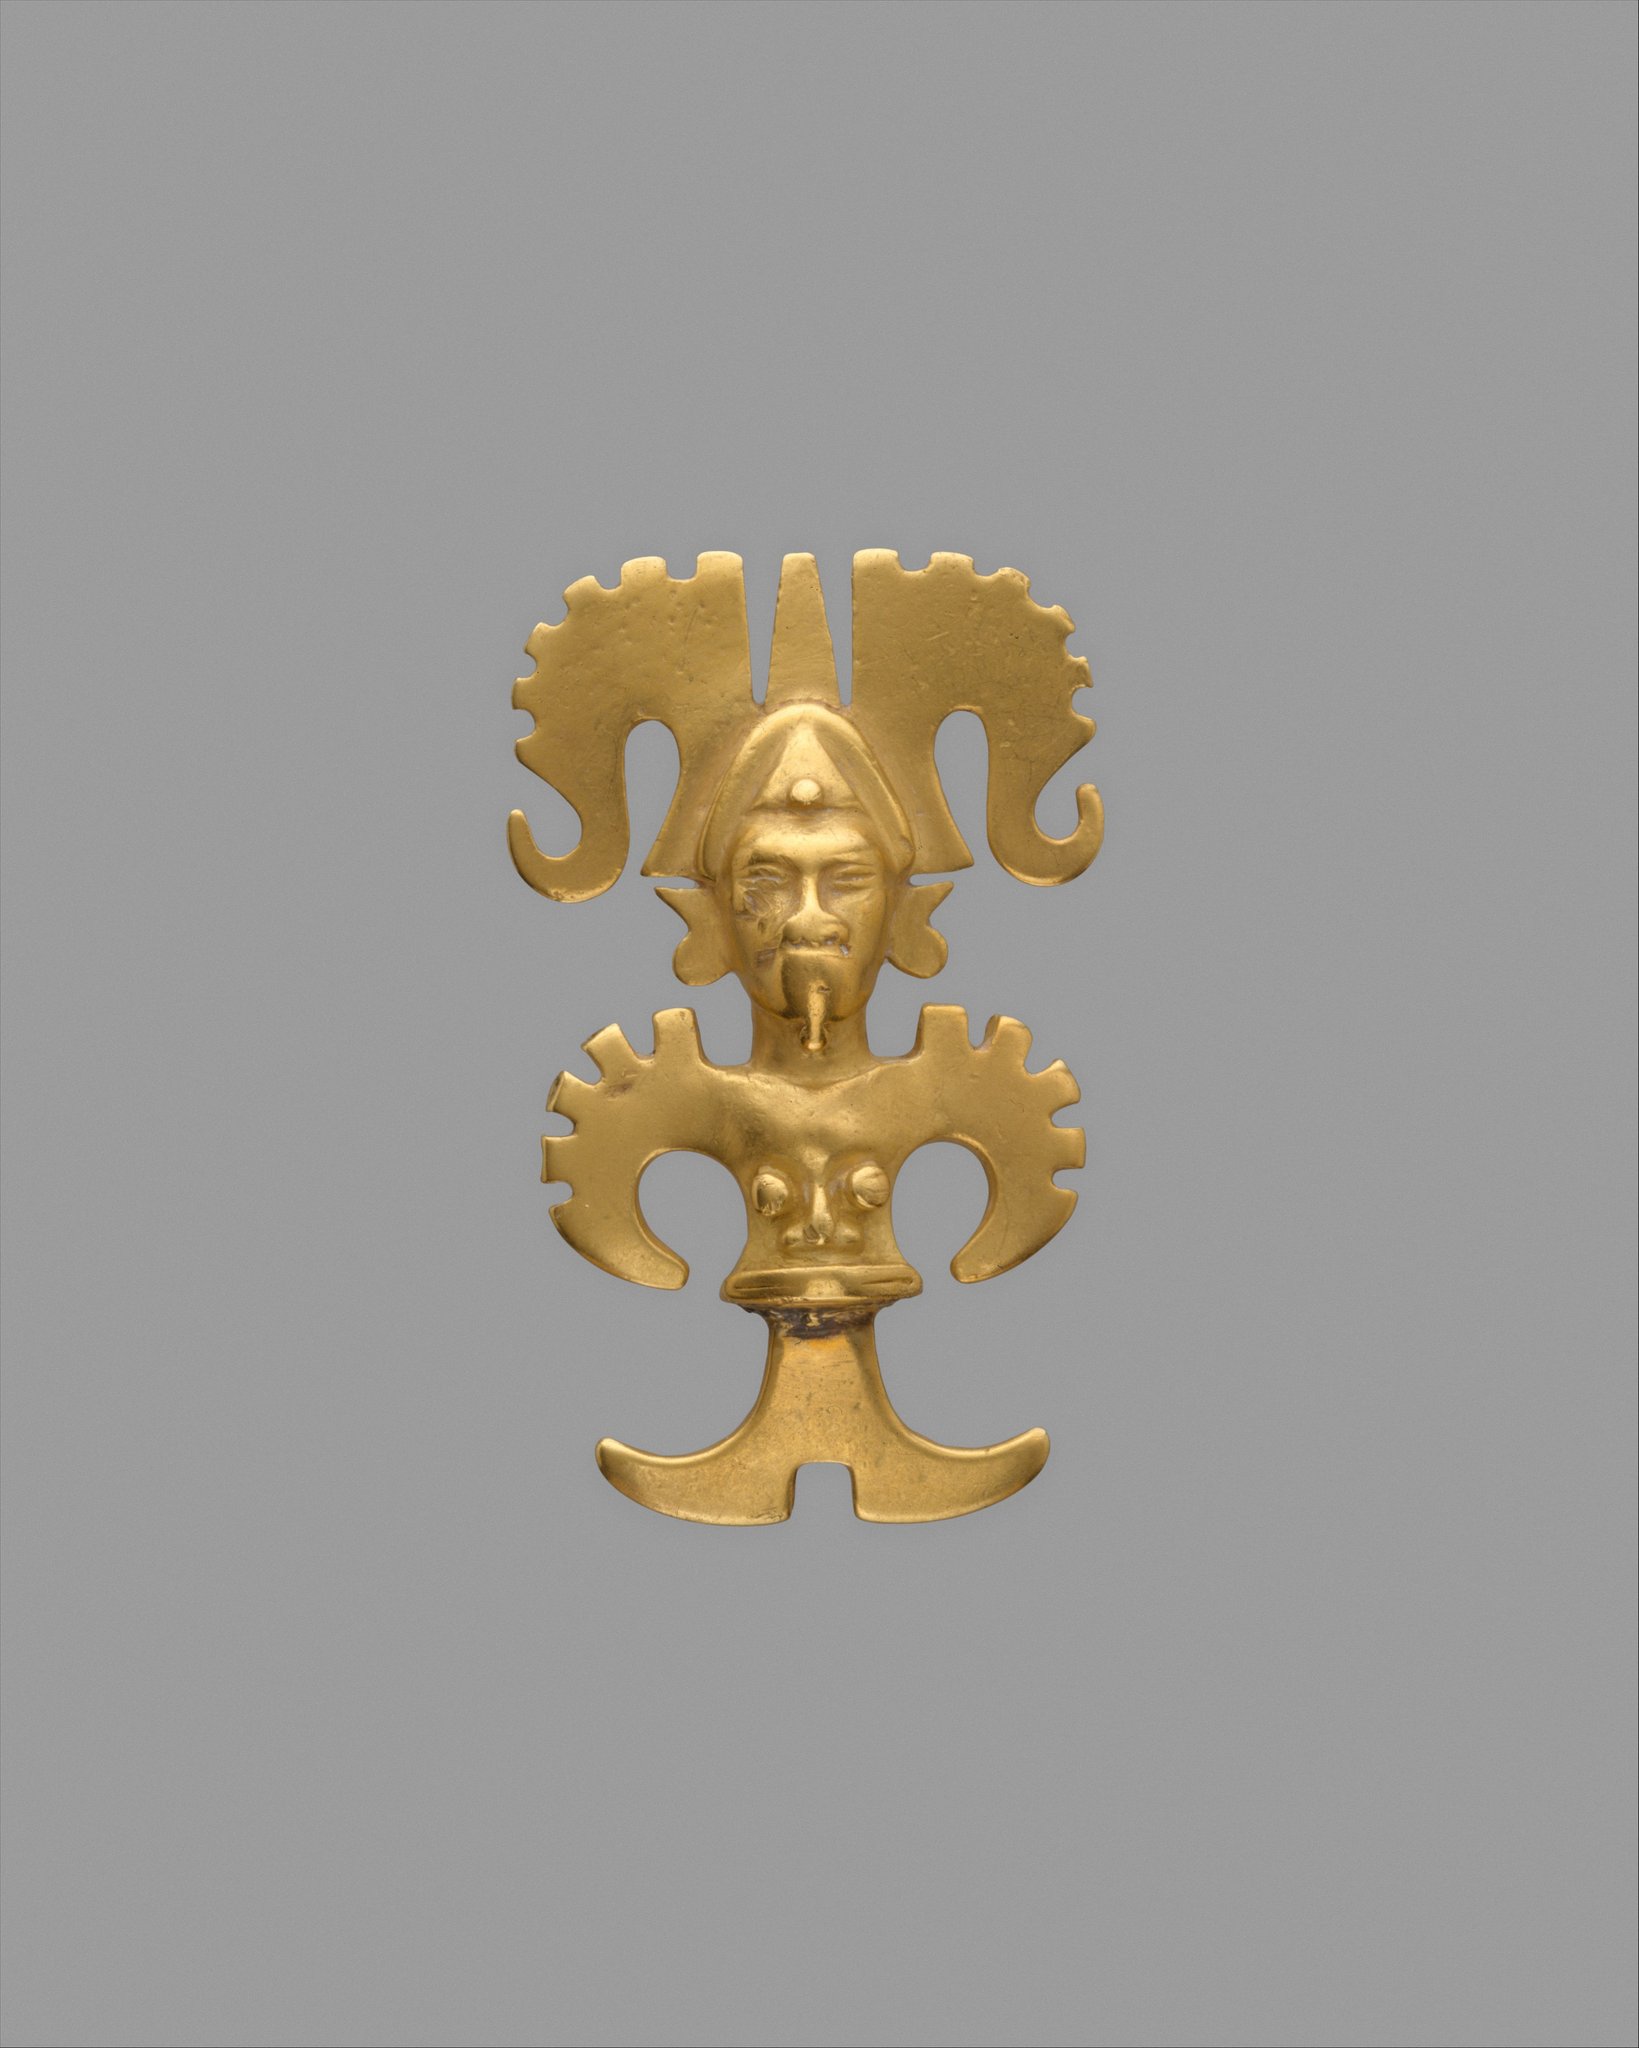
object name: pendant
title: Stylized Figure Pendant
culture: international or initial style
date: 401-1000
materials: gold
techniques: casting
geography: panama